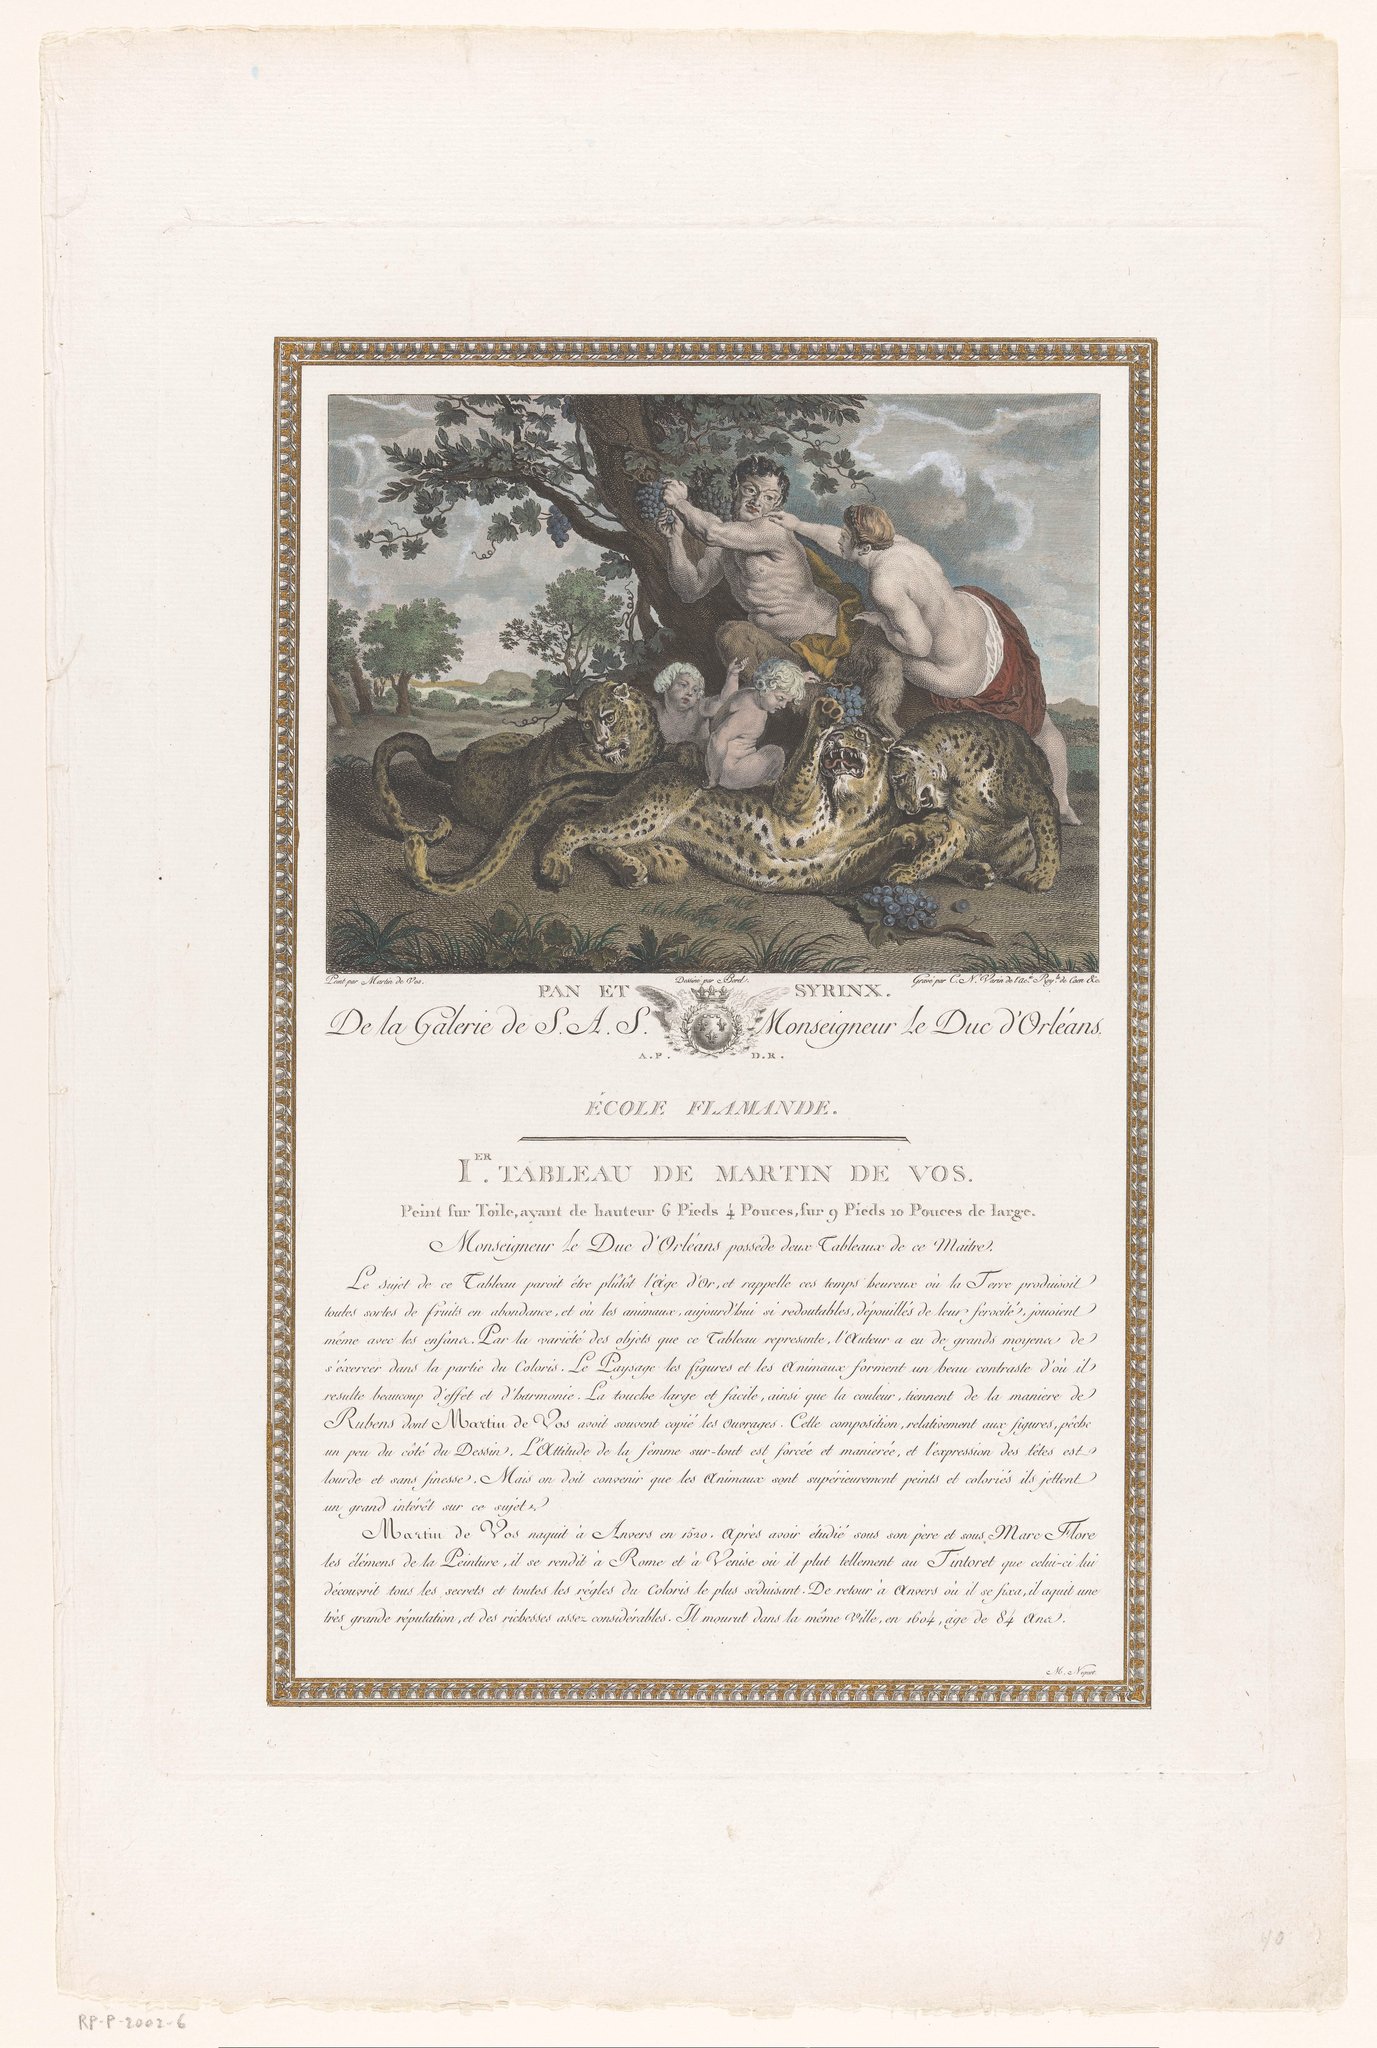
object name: print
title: Pan en Syrinx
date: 1786-1808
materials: paper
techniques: engraving, etching, hand coloring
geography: paris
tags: armorial bearing, heraldry, syrinx changed into a reed: while fleeing from pan, the nymph syrinx is changed into reed by her sisters, the naiads (ovid, metamorphoses i 705)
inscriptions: collector's mark: Lugt 2760, collector's mark: Lugt 2228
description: Onderdeel van een serie van 354 prenten naar schilderijen uit de collectie van de Hertog van Orléans, getiteld: La Galerie du Palais Royal, uitgebracht tussen 1786 en 1808. De serie werd uitgegeven door Jacques Couché die het project samen met Jacques Bouillard leidde.